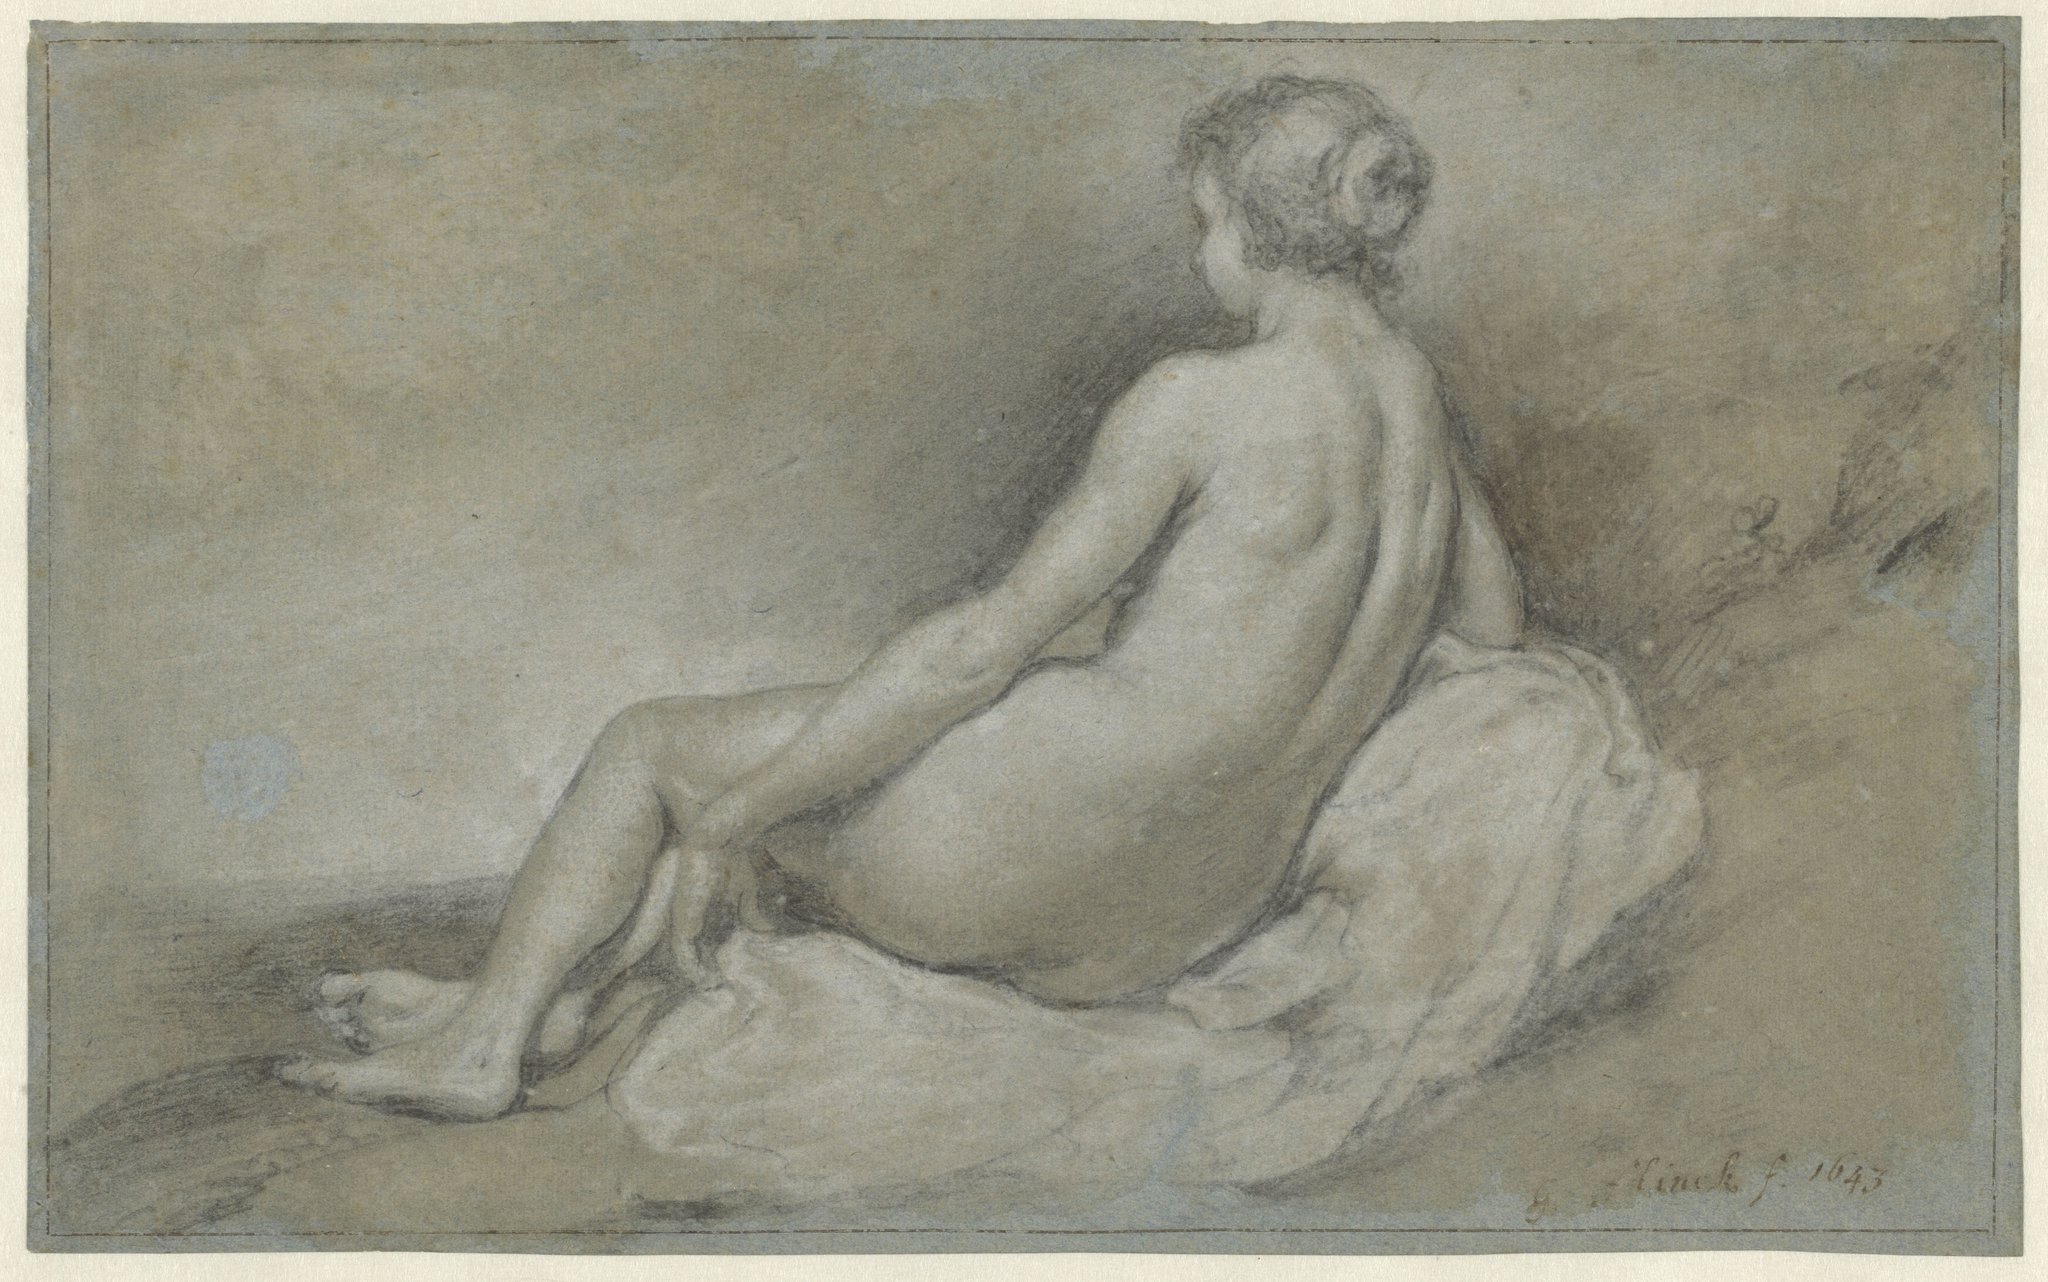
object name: drawing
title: Zittend vrouwelijk naakt, op de rug gezien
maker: govert flinck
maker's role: draughtsman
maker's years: 1615-1660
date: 1643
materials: chalk, paper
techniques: brush